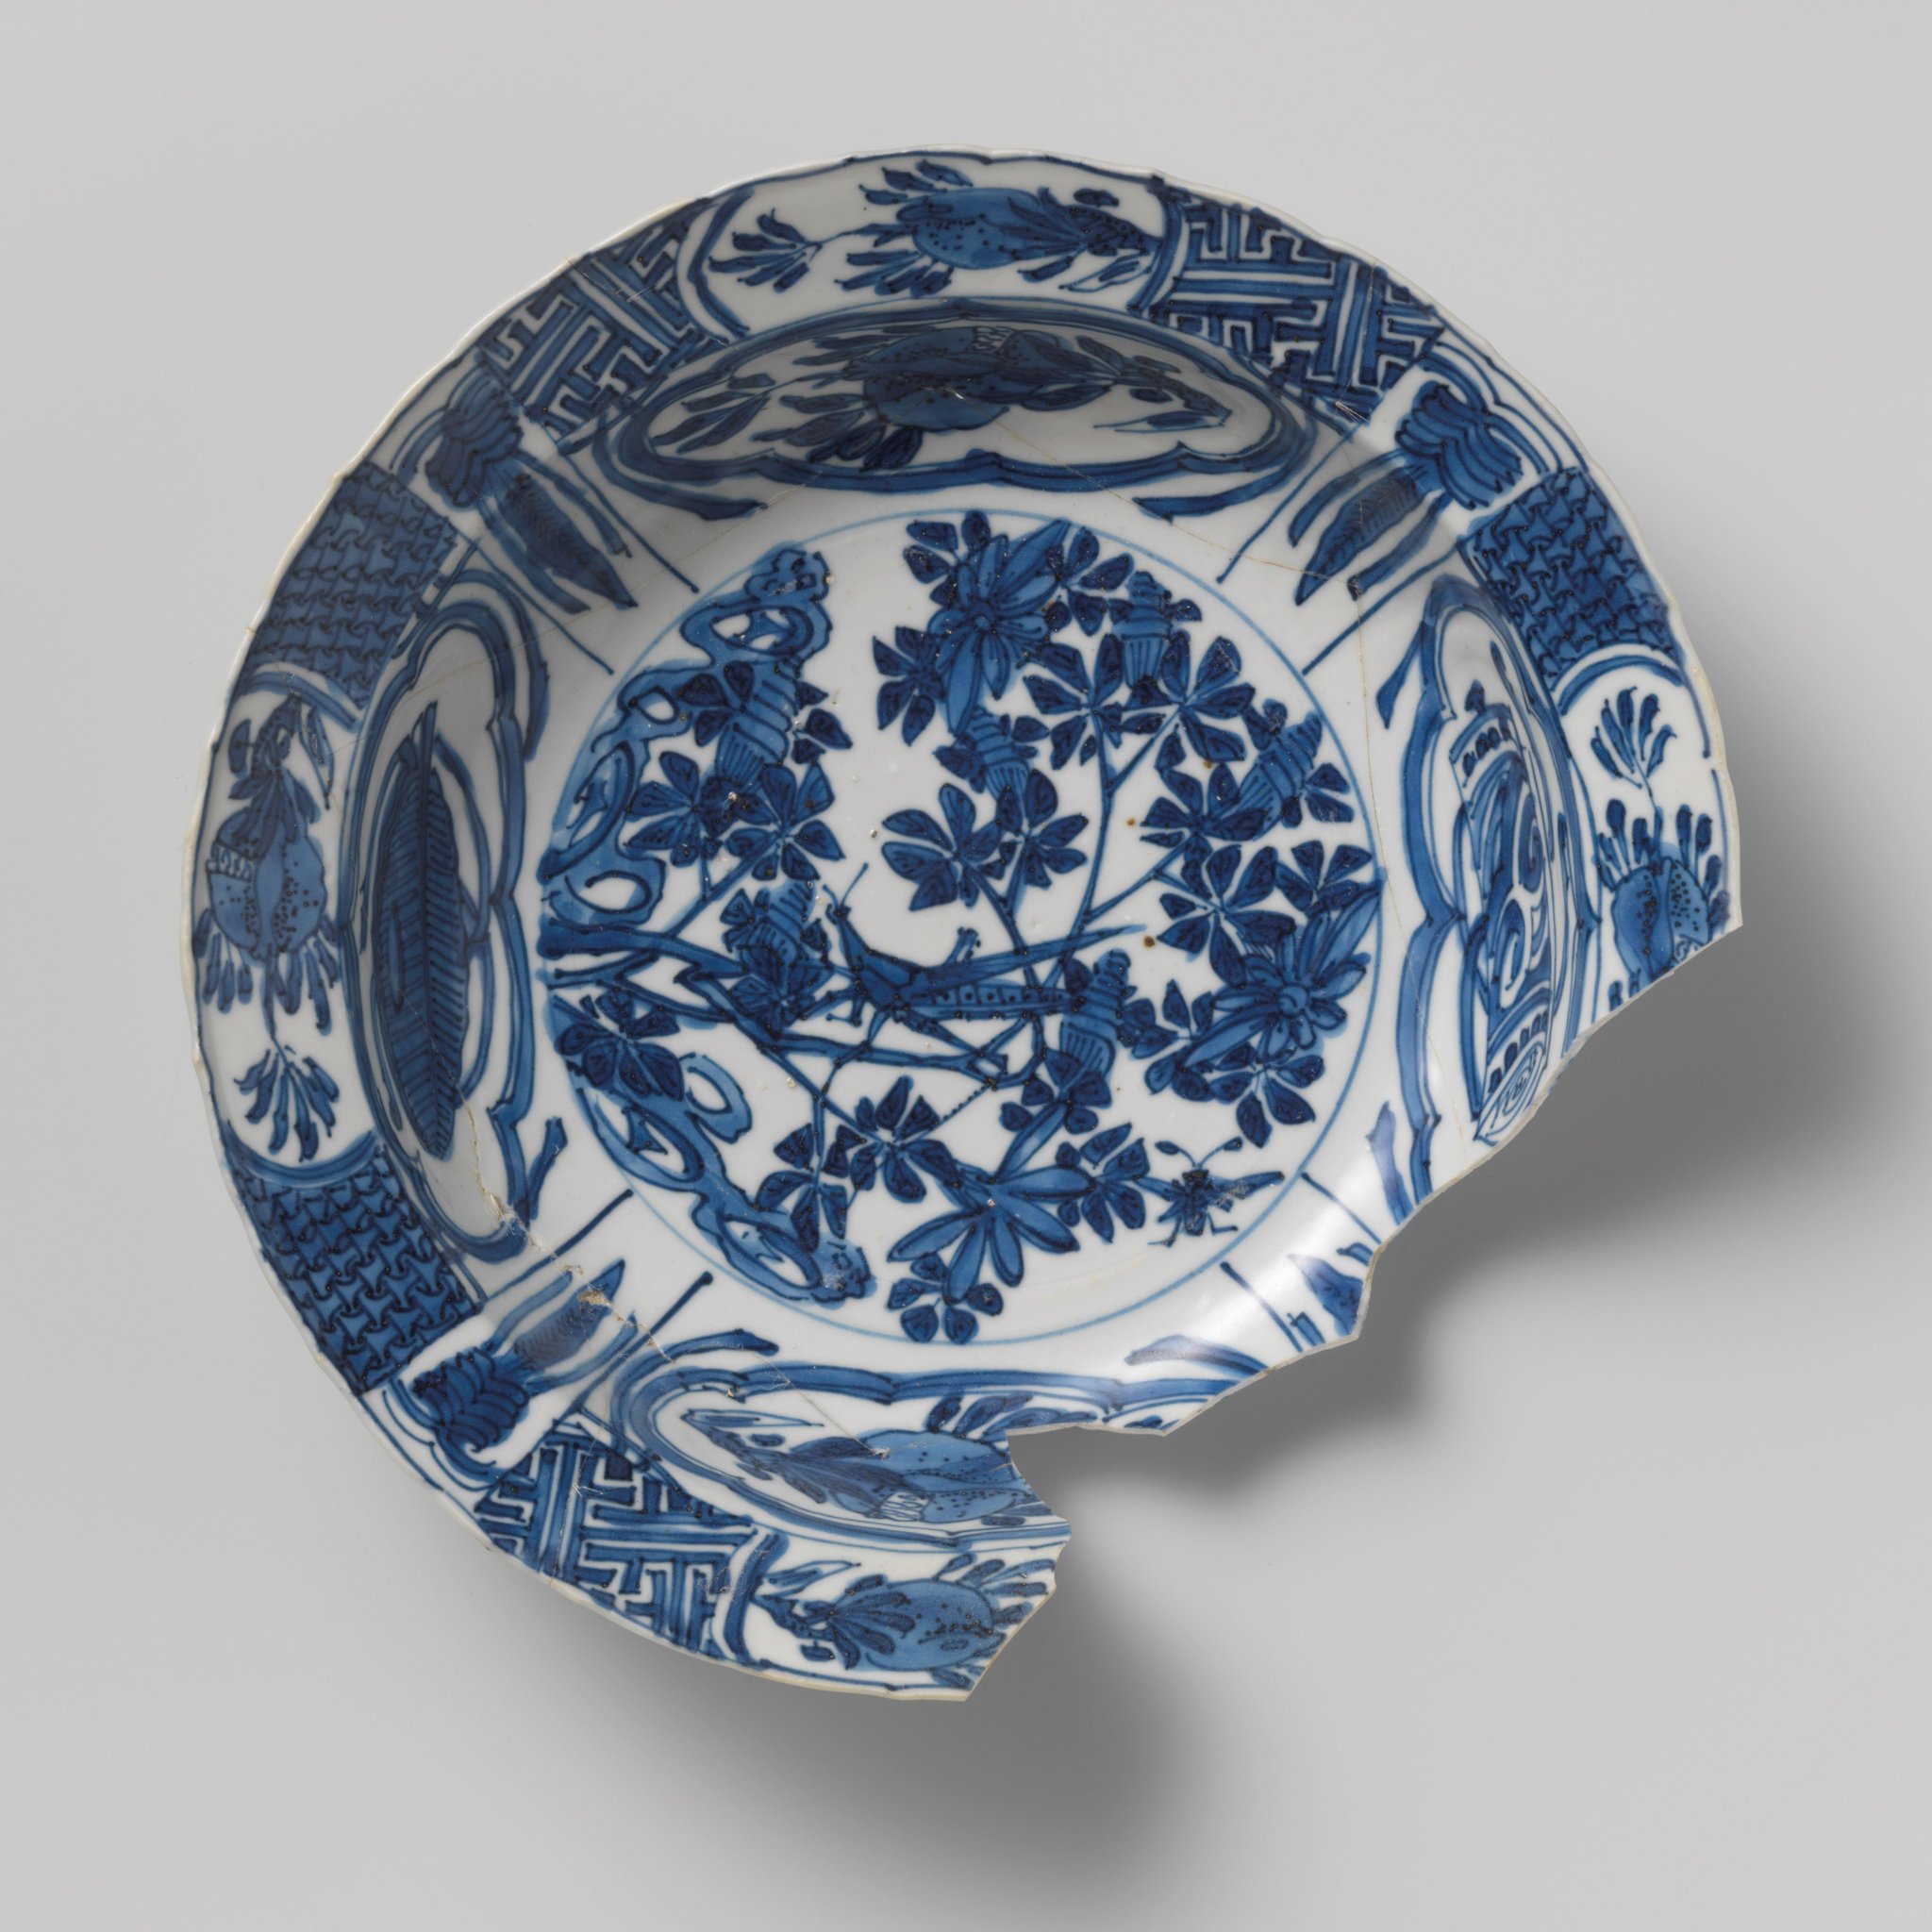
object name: deep dish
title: Fragment diep bord uit V.O.C.-schip de 'Witte Leeuw'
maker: Anonymous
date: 1613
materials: bone china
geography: jingdezhen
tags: verenigde oostindische compagnie, sint-helena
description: A bowl with a flattened rim. Cartouches with fruits enclosed by diaper patterns. A central decoration of a grasshopper in a mulberry-tree with cocoons. Panels decorated with fruits and symbols.